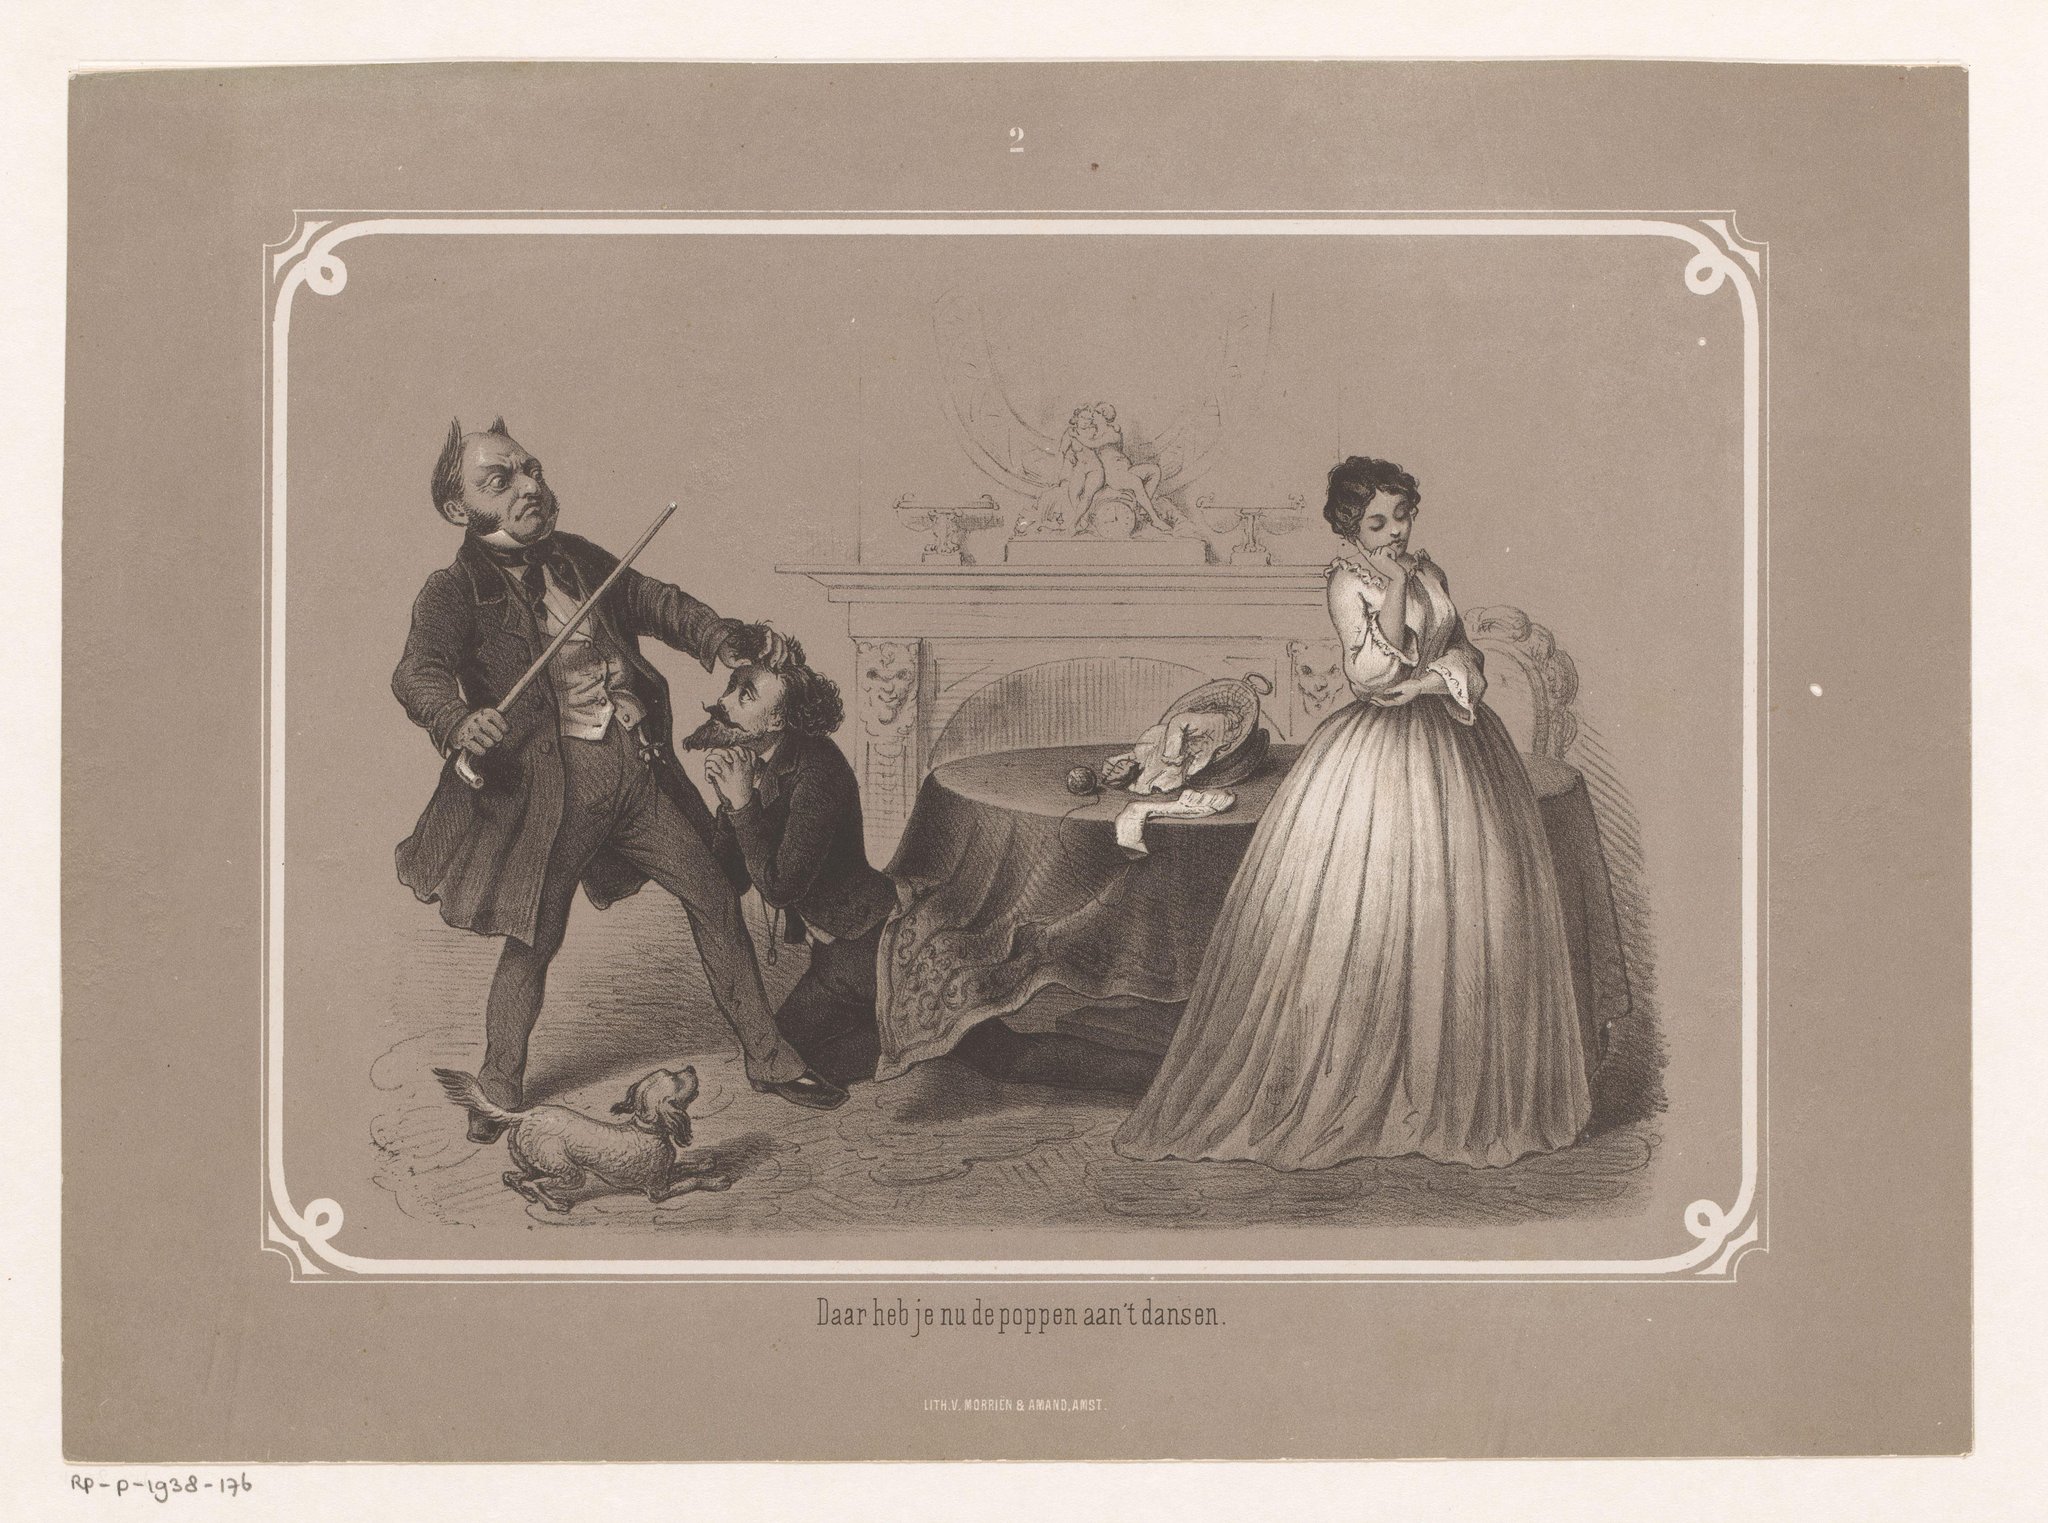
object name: print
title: Spreekwoord: de poppen aan het dansen hebben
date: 1865-1866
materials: paper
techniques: tone lithography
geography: amsterdam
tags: couple of lovers, being dragged, hidden love discovered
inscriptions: collector's mark: Lugt 2228, collector's mark: Lugt 2760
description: De minnaar had zich onder de tafel verstopt en wordt aan zijn haren daar onder vandaan getrokken. Rechts staat de vrouw met afgewende blik.